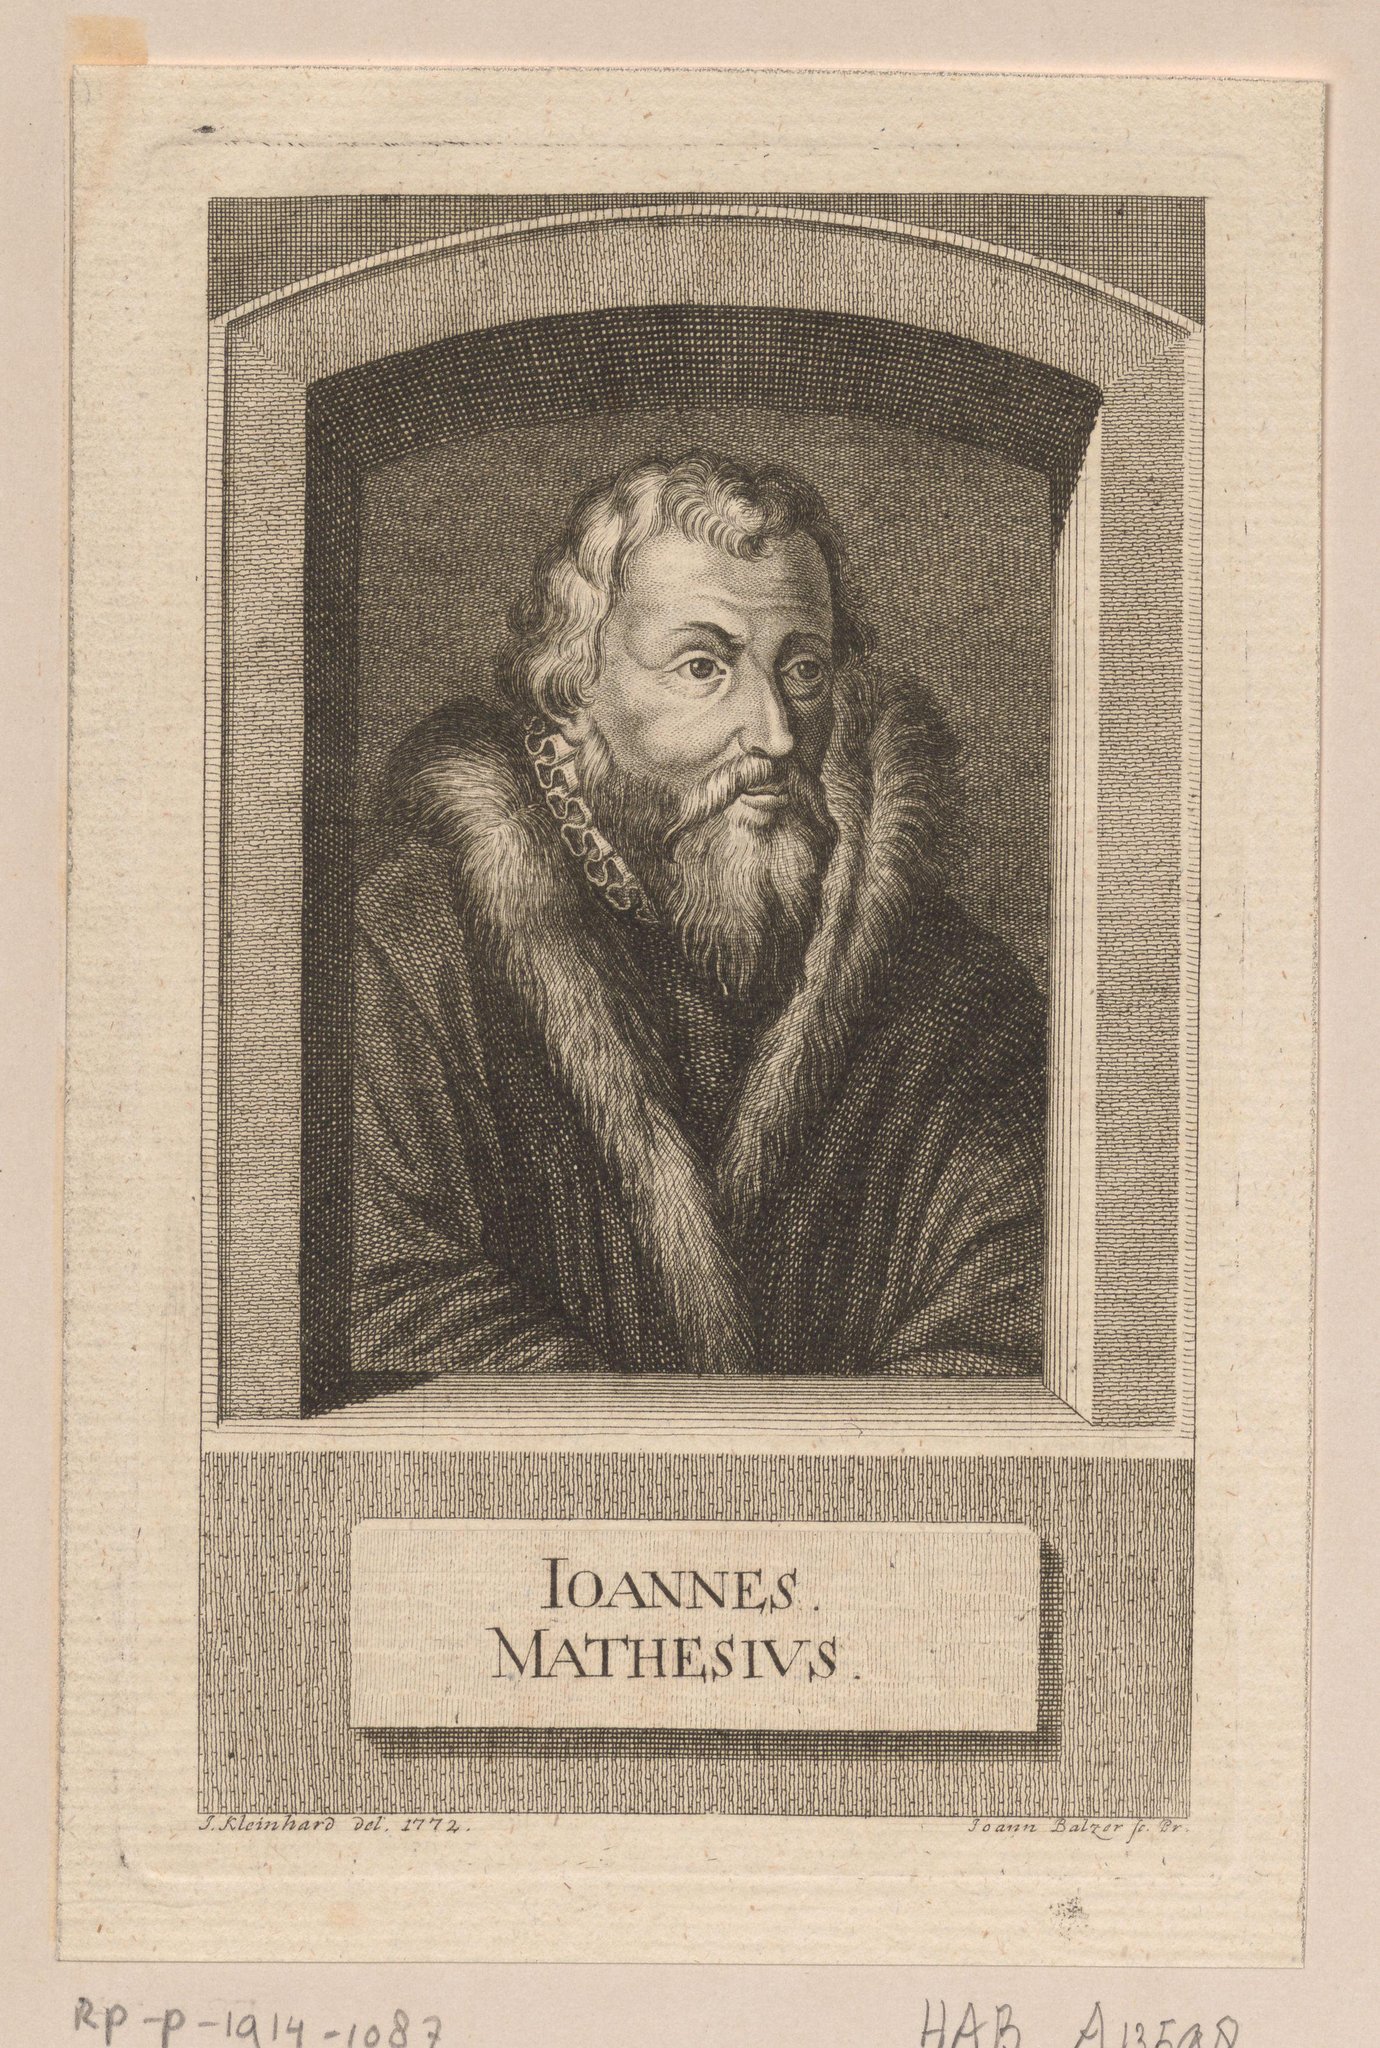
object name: print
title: Portret van Johannes Mathesius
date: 1772-1799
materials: paper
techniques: etching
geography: prague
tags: theologian, historical persons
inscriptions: collector's mark: Lugt 2228